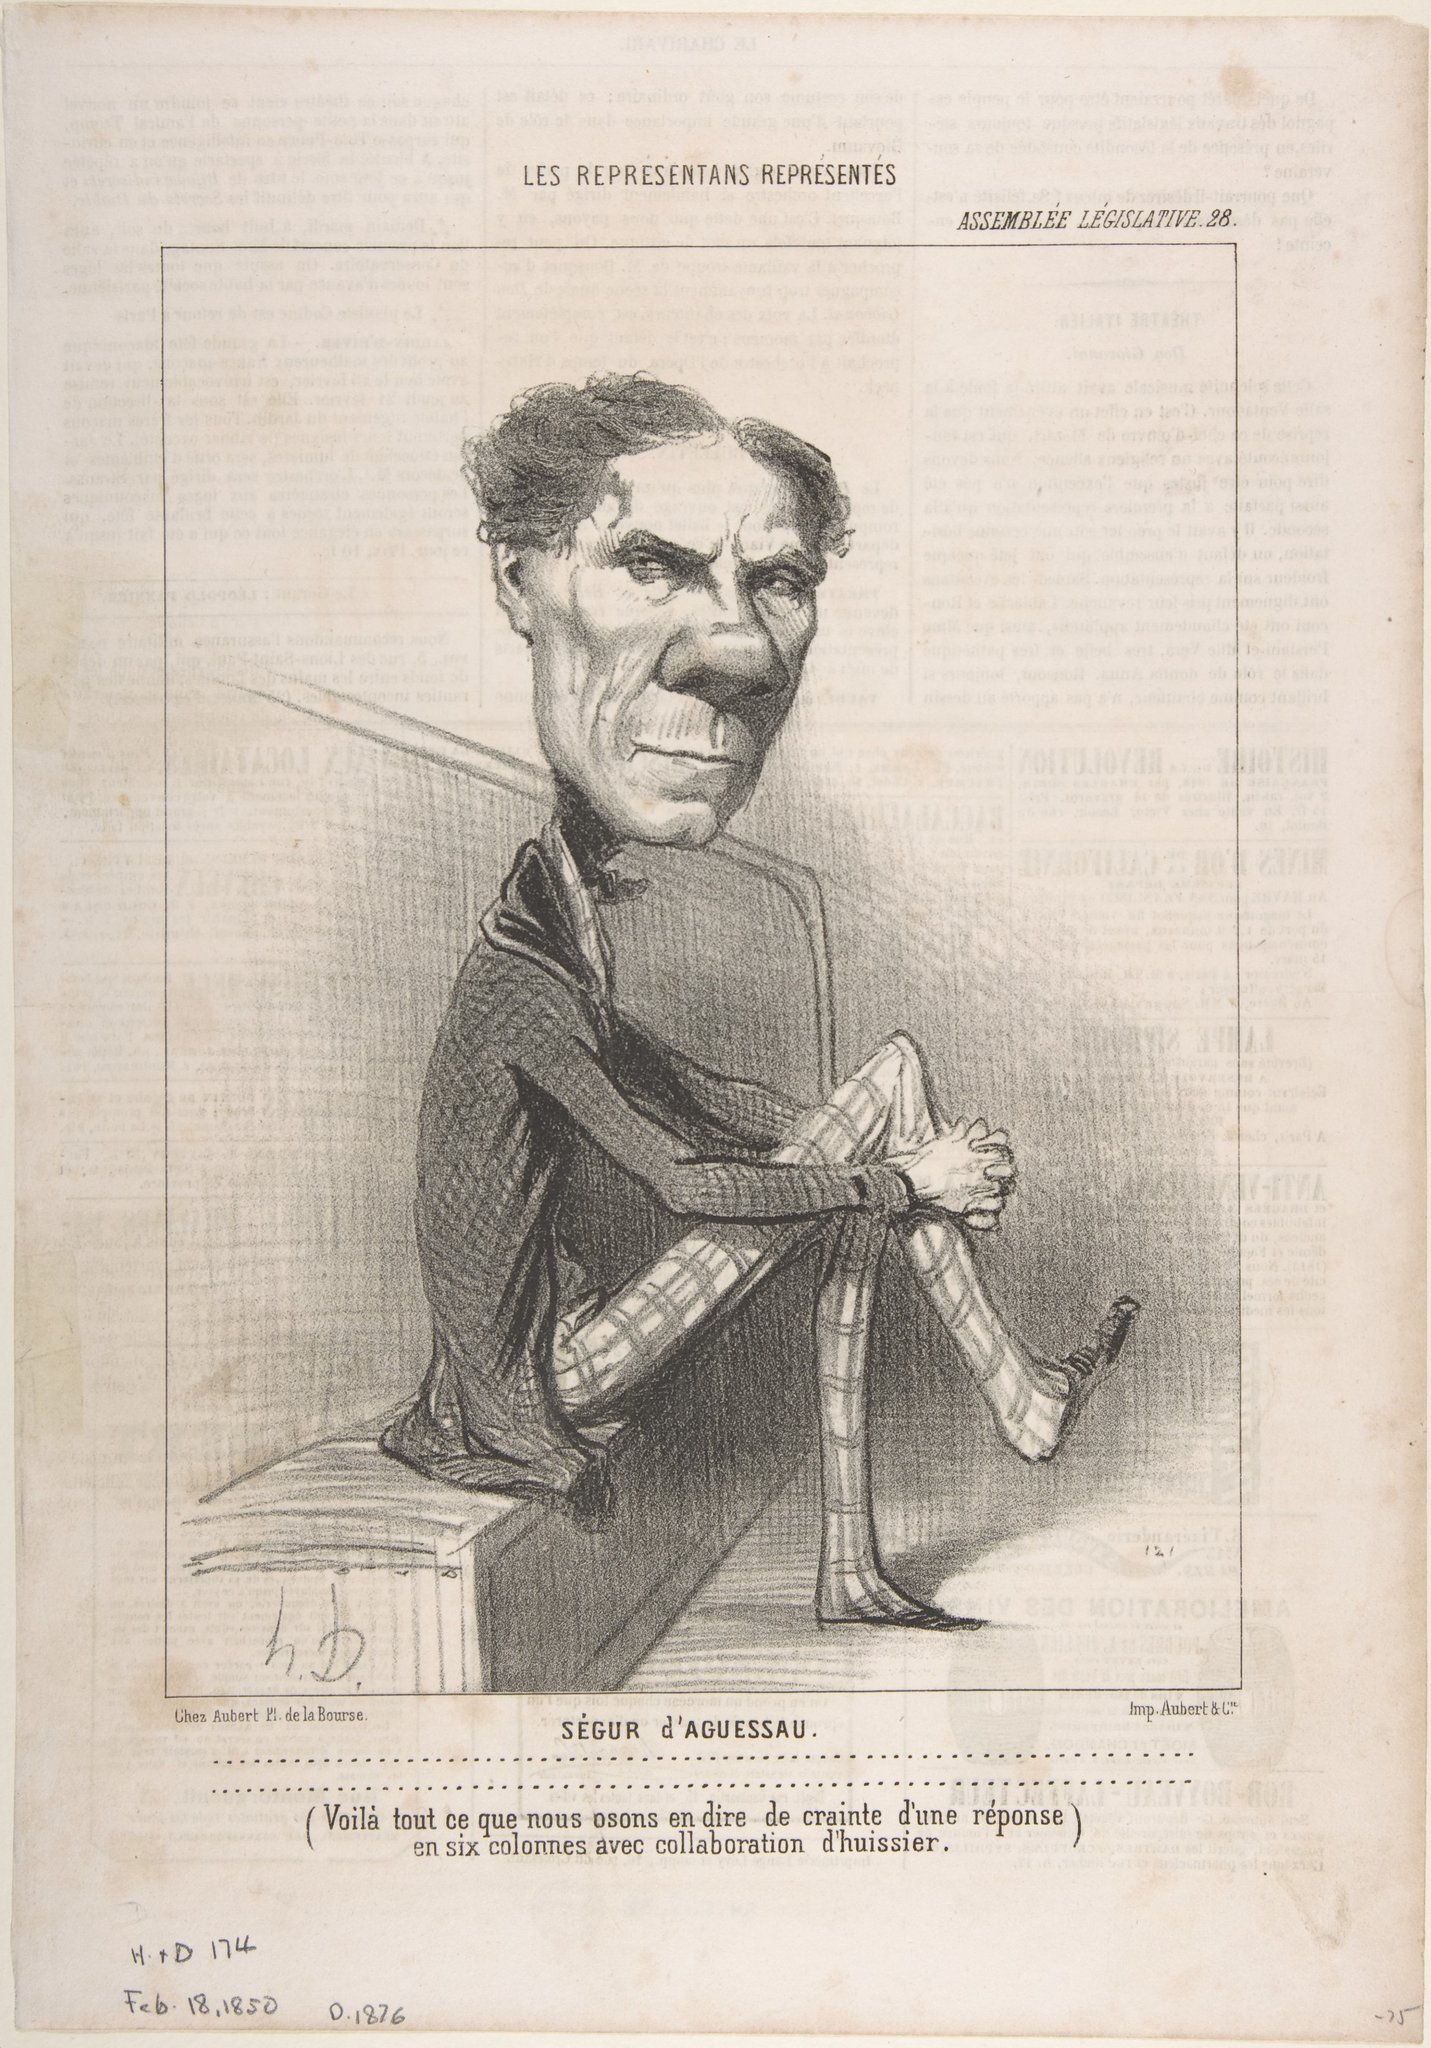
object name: print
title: Ségur d'Aguessau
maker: honoré daumier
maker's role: artist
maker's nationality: french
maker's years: 1808-1879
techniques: lithograph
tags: men,caricature